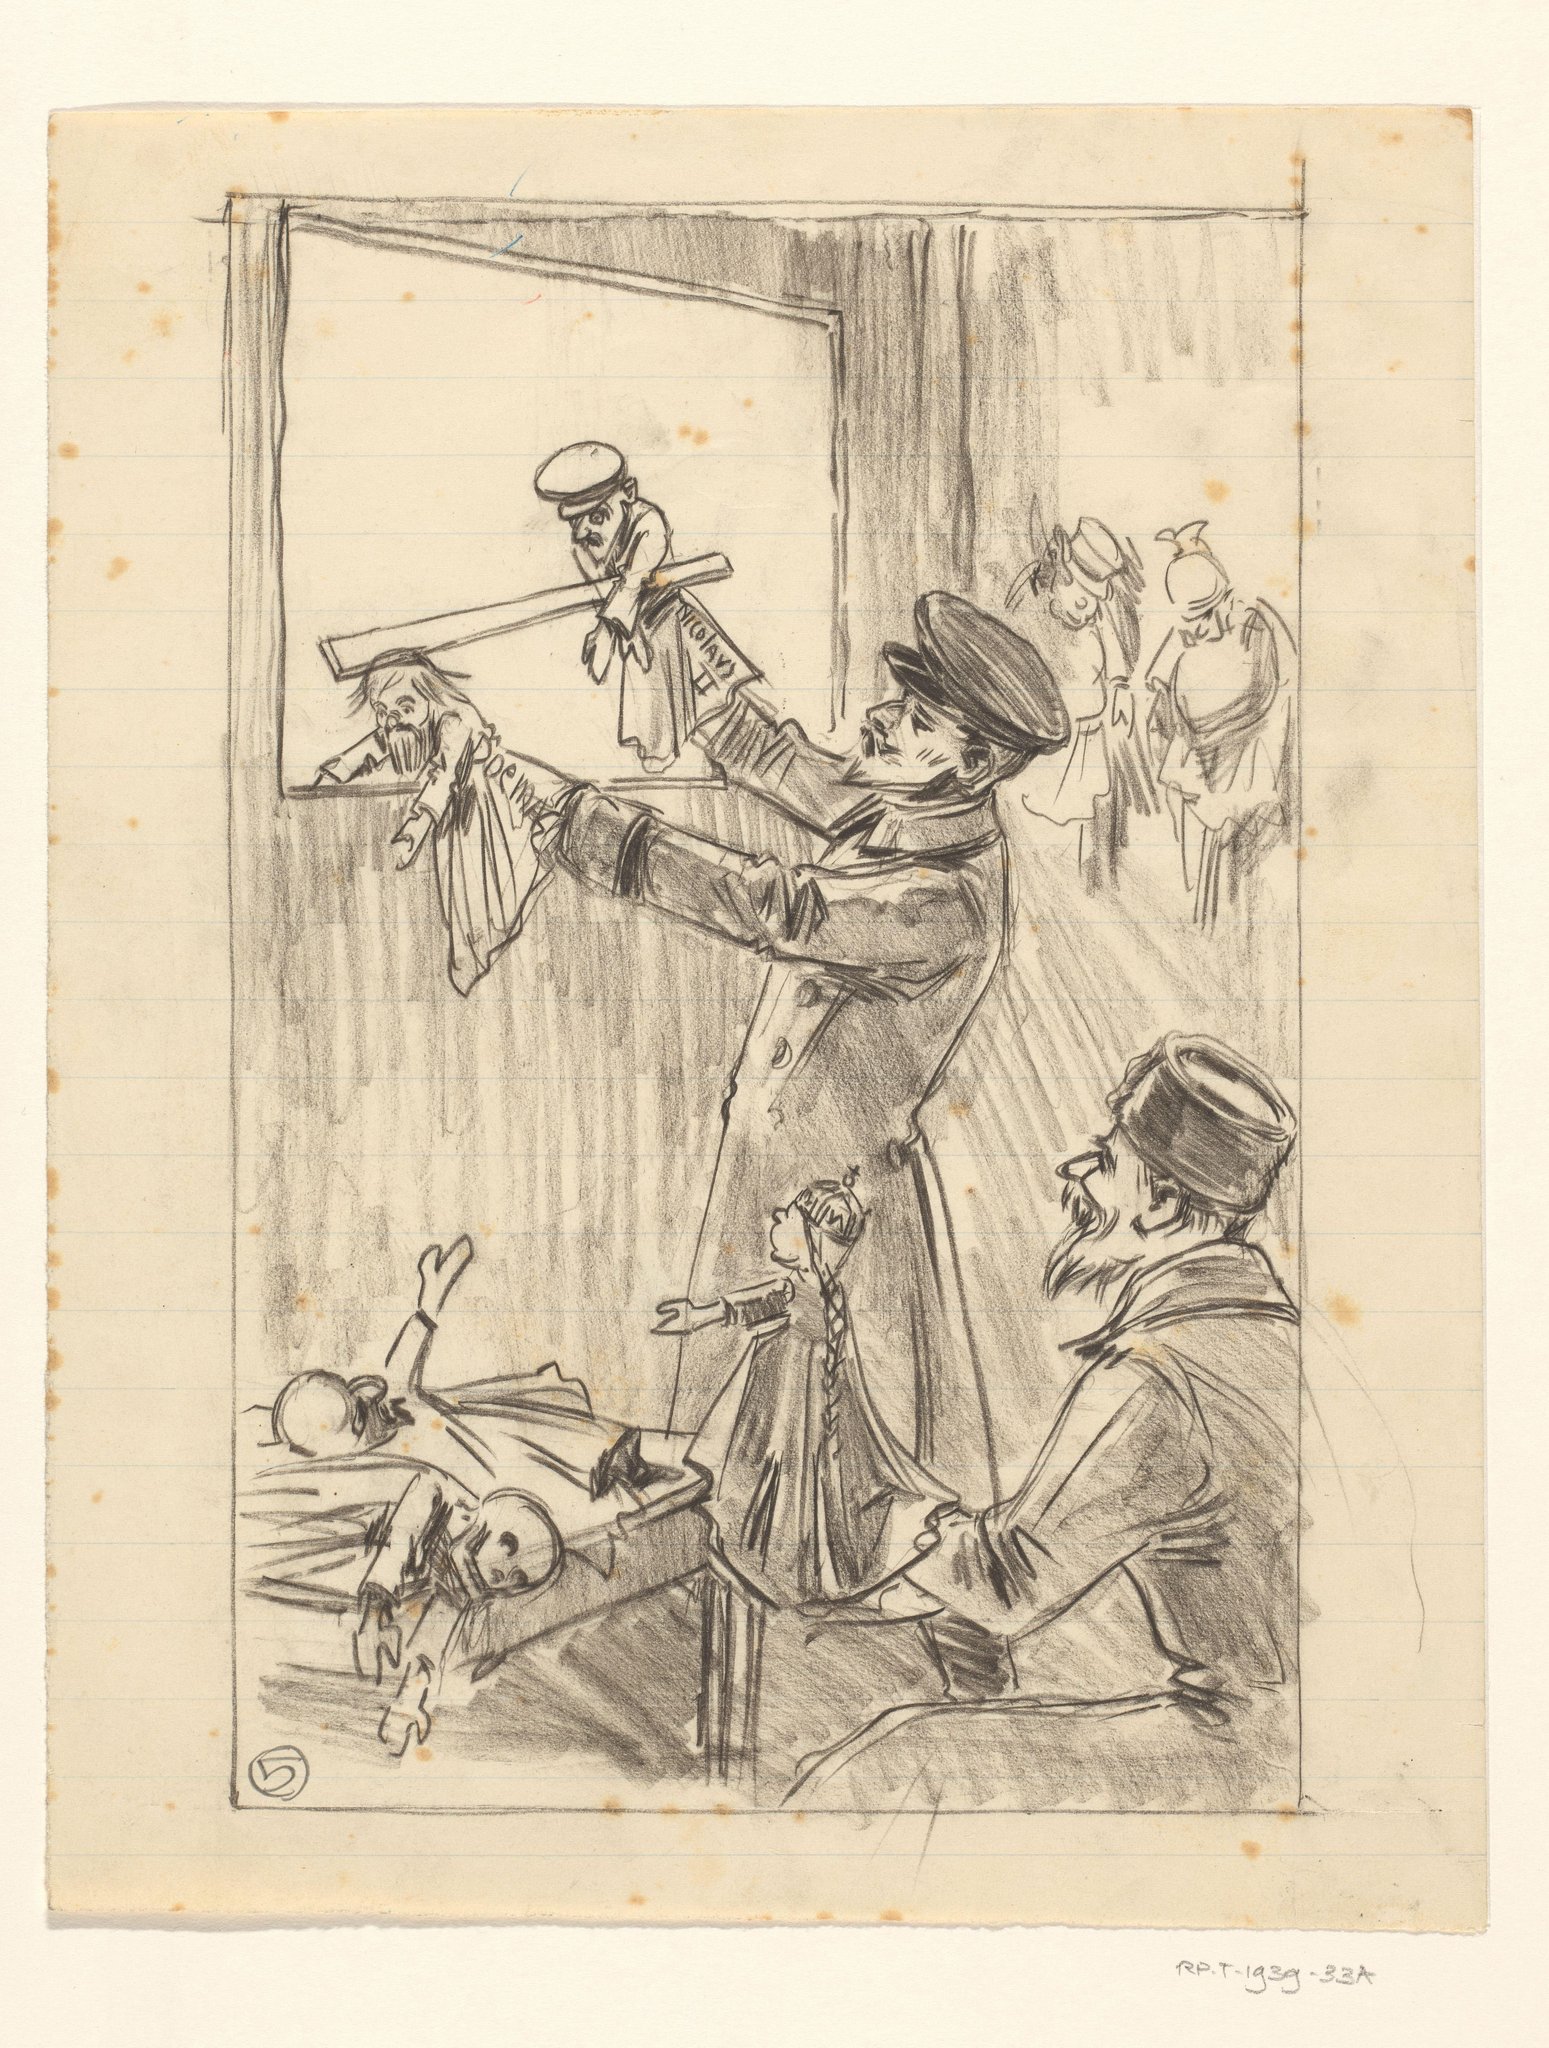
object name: design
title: Ontwerp voor een spotprent op tsaar Nicolaas II van Rusland en de Doema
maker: henricus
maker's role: draughtsman, print maker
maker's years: 1867-1921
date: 1906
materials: chalk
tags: puppet and marionette show, political caricatures and satires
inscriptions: collector's mark: Lugt 2228a, number: ‘5’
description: Een man in uniform staat achter een poppenkast en speelt een voorstelling met twee poppen. Een pop met de naam 'Nicolaus II' laat een plank vallen op het hoofd van een pop met de naam 'Doema'.